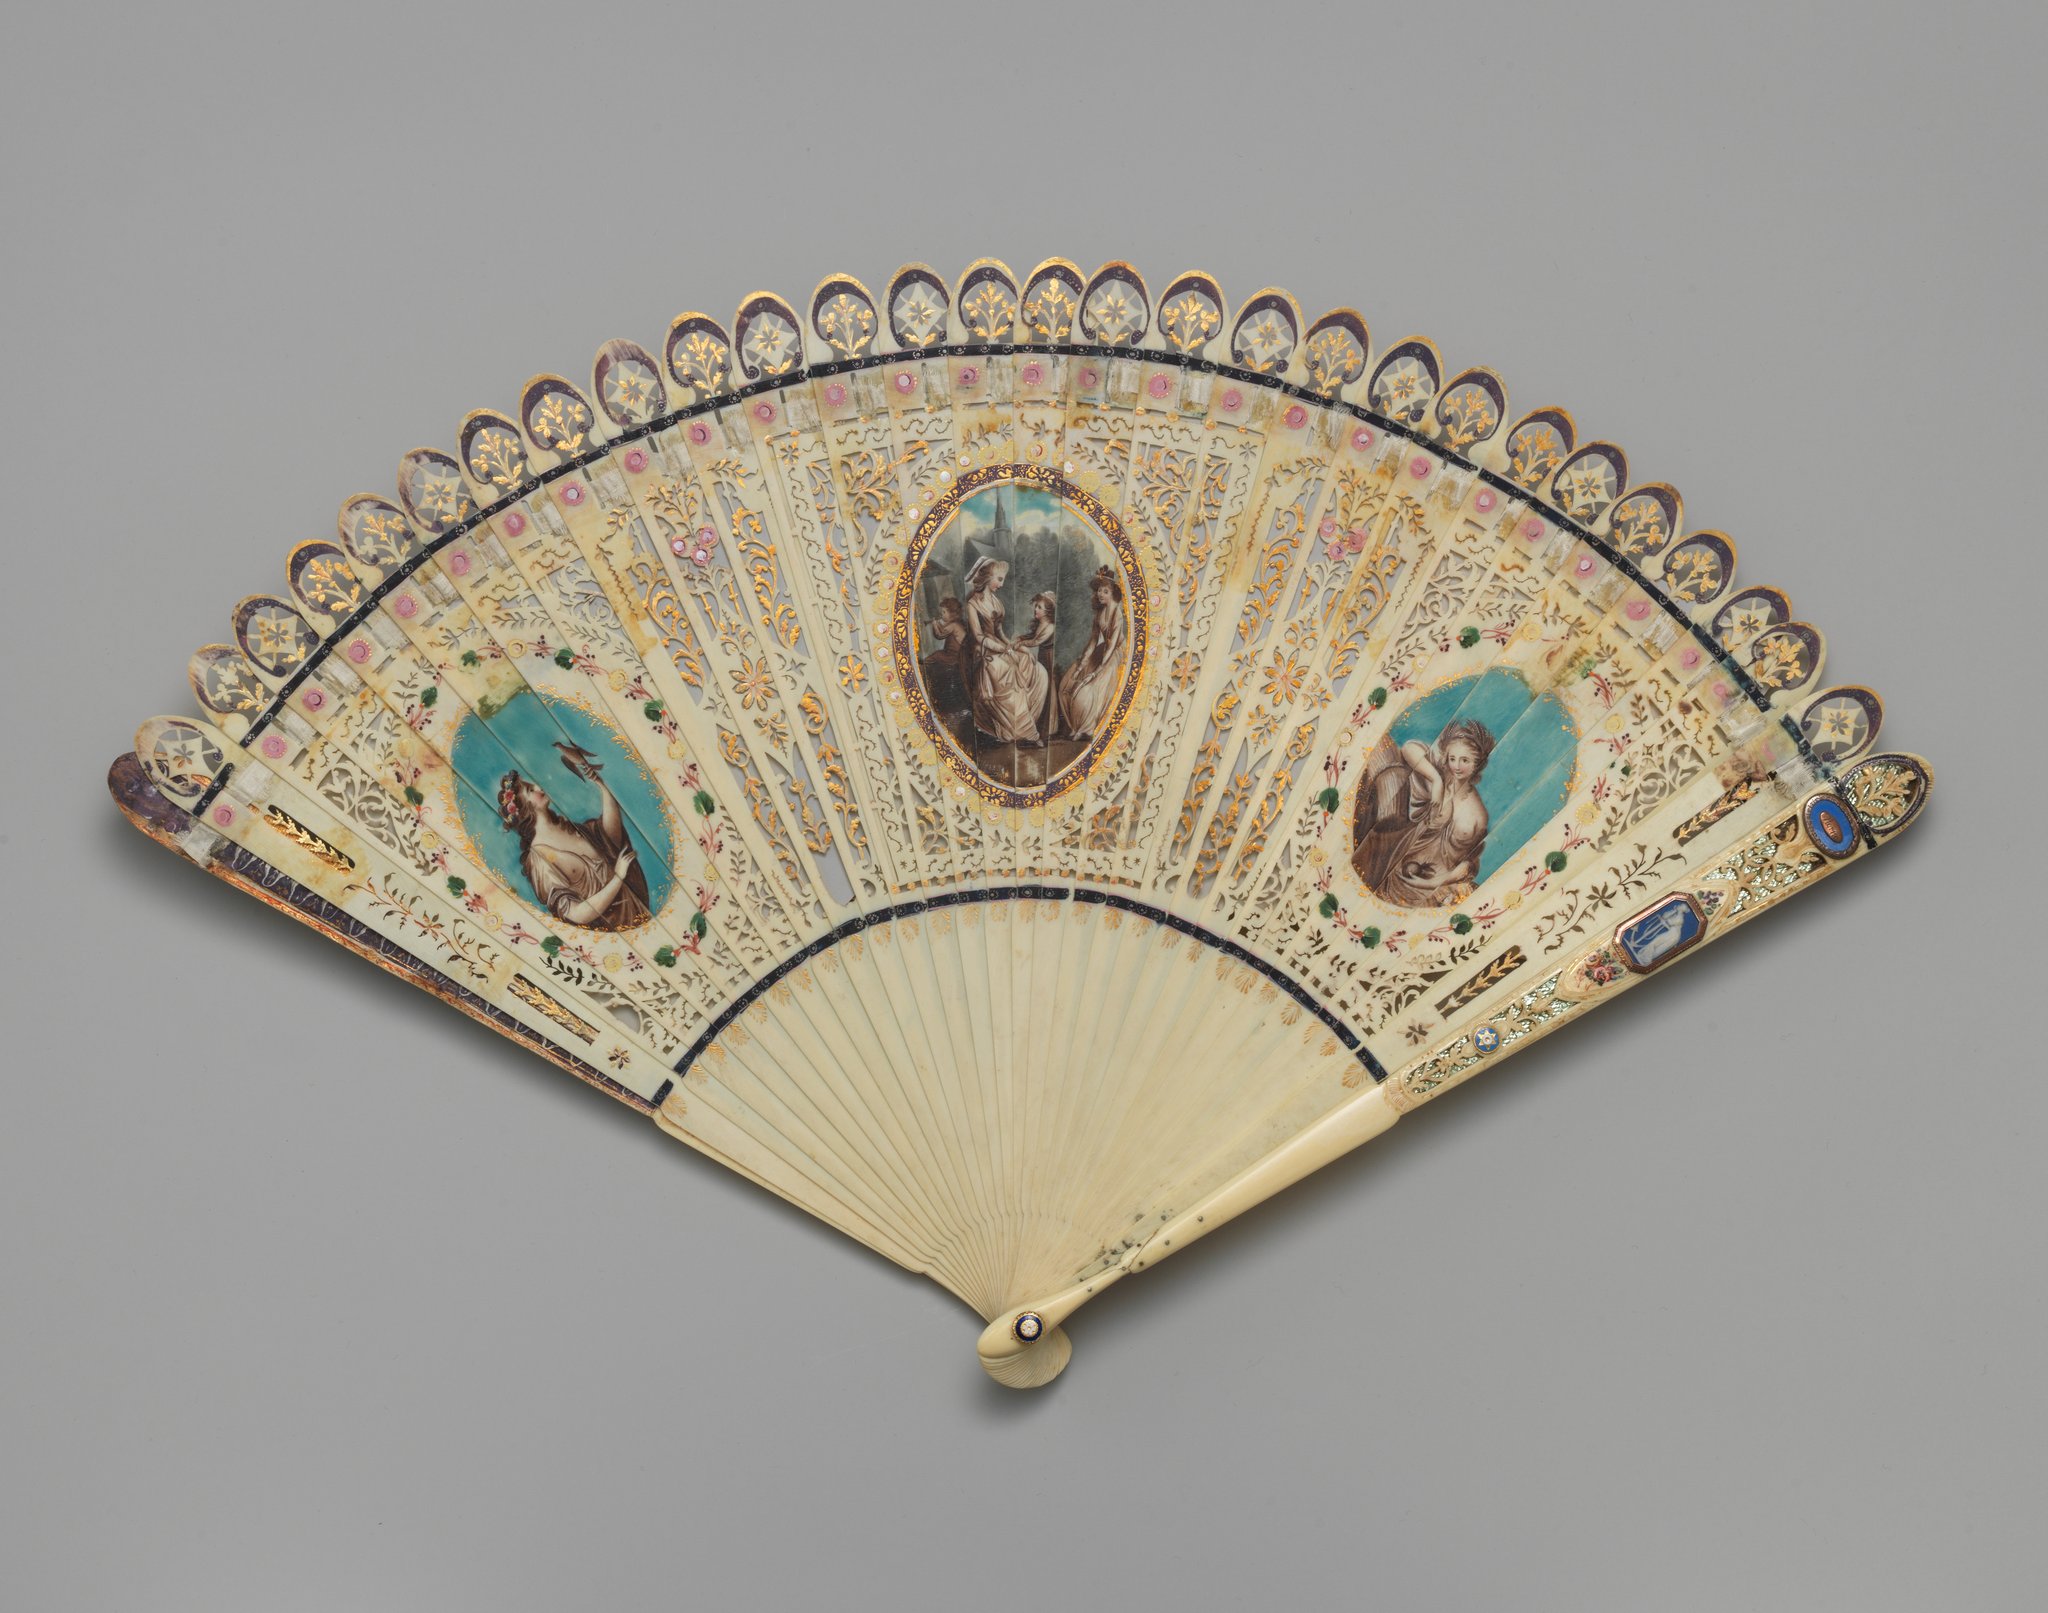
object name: fan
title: Brisé fan with three painted reserves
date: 1767-1800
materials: glass, ivory, metal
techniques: enamel, gilding, painting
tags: birds,women